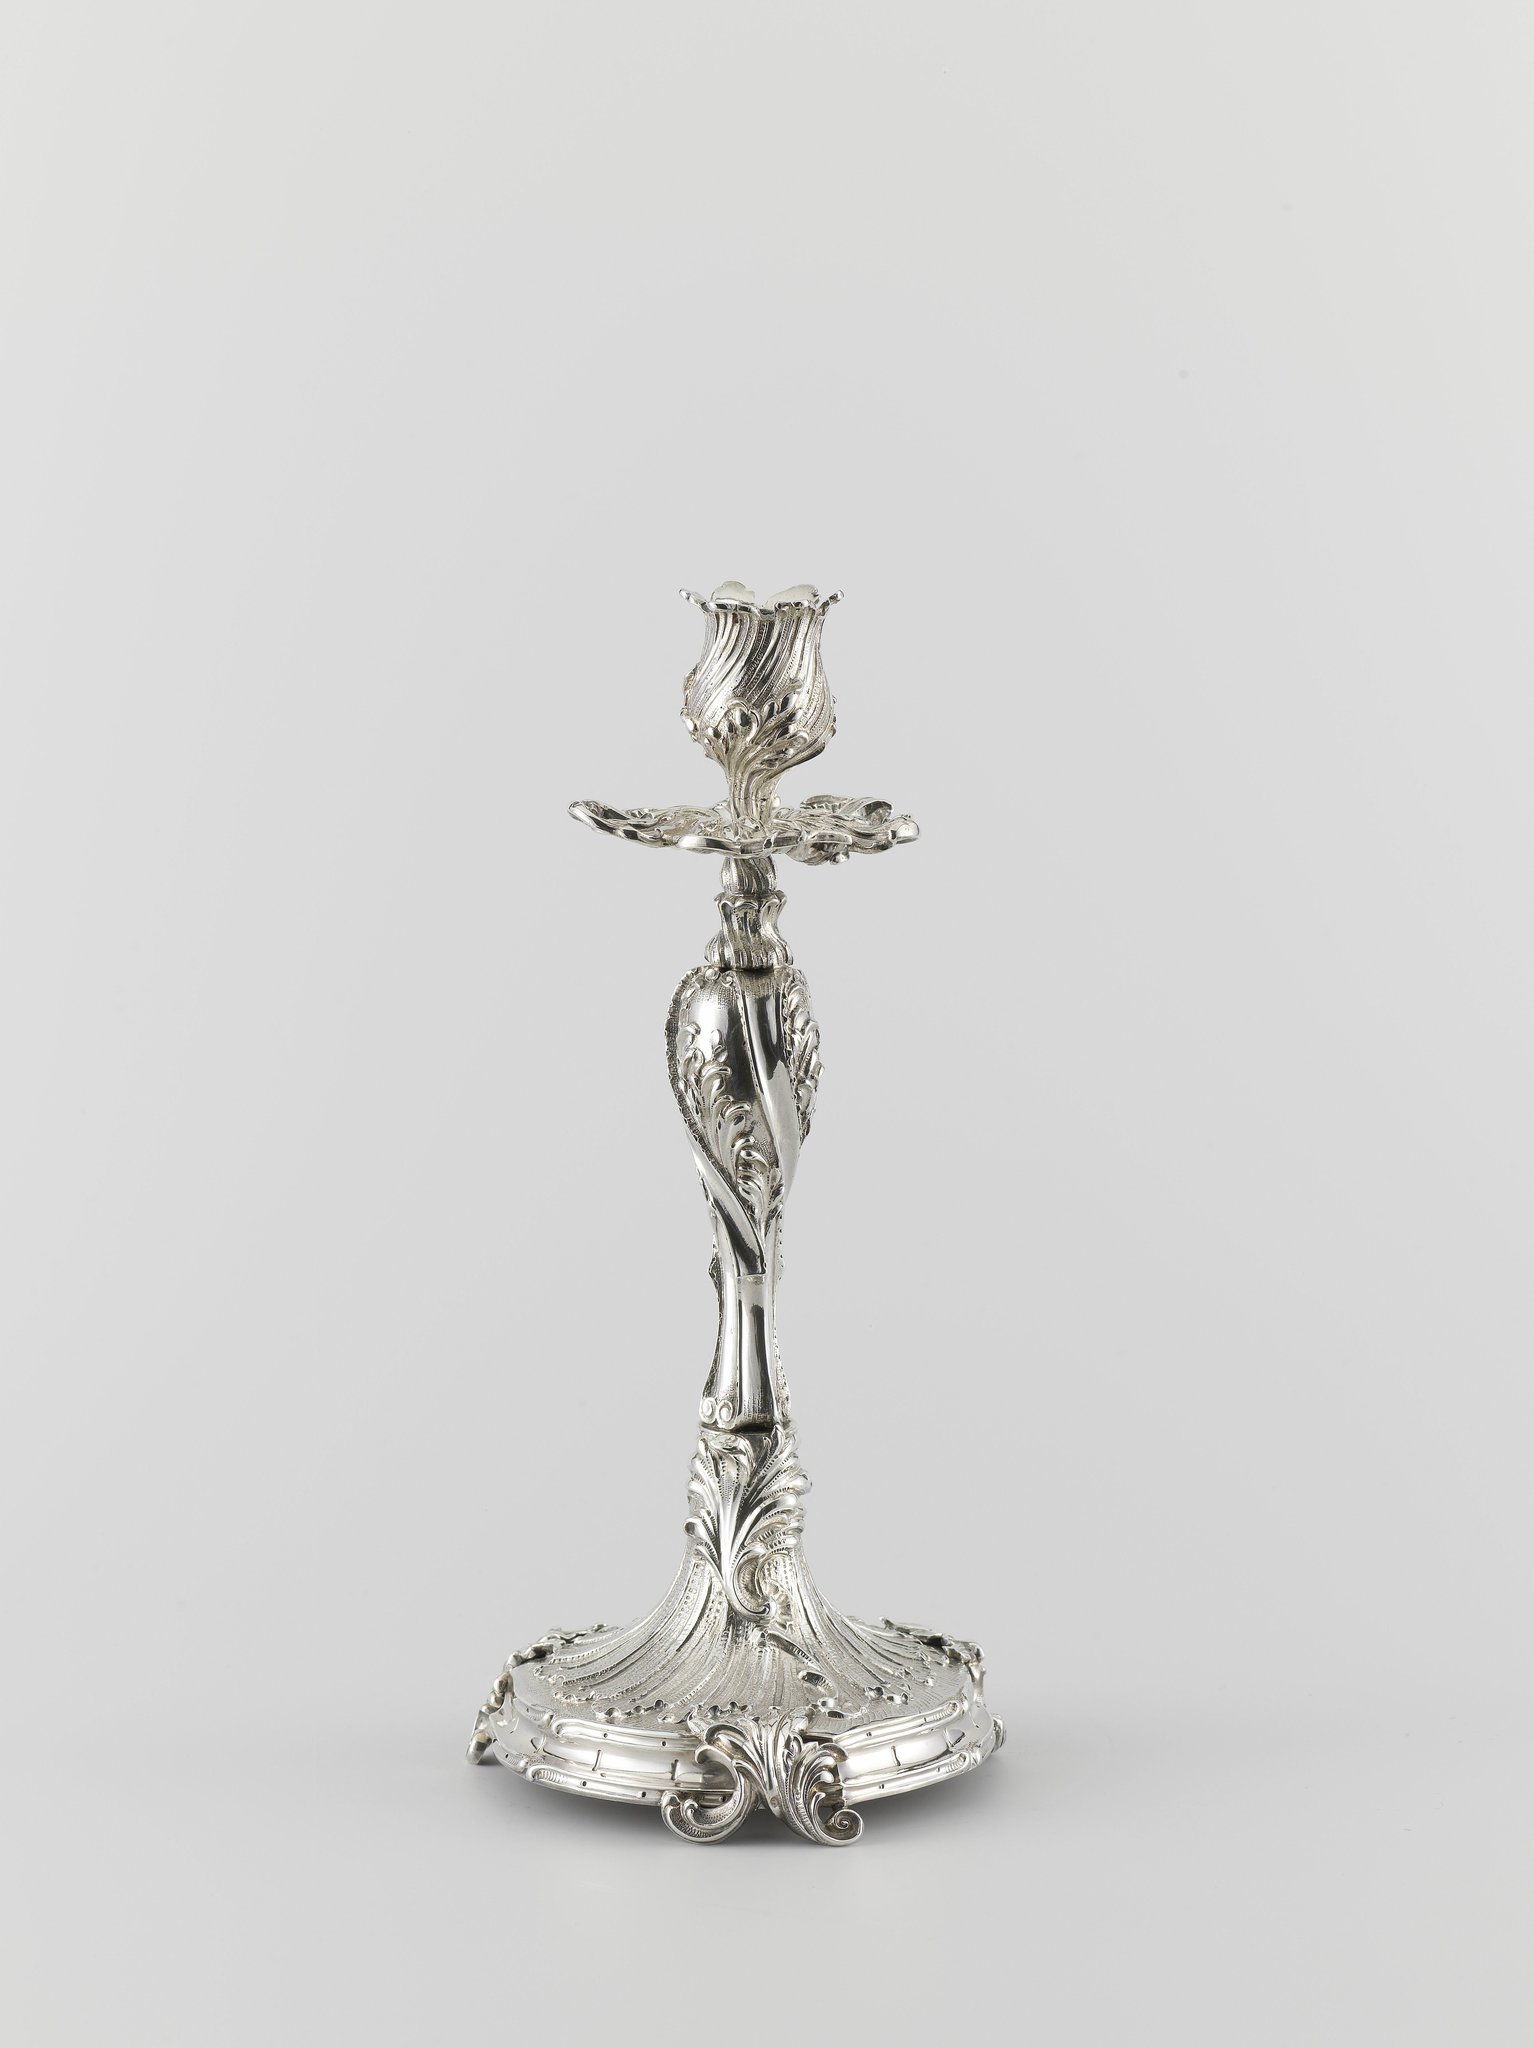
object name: candlestick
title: Kandelaar, deel van een ensemble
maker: karel sluijterman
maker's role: designer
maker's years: 1863-1931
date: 1891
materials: silver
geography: amsterdam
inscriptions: assay office mark, assayer's mark, alloy mark, maker's mark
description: Kandelaar van zilver, deel van een ensemble